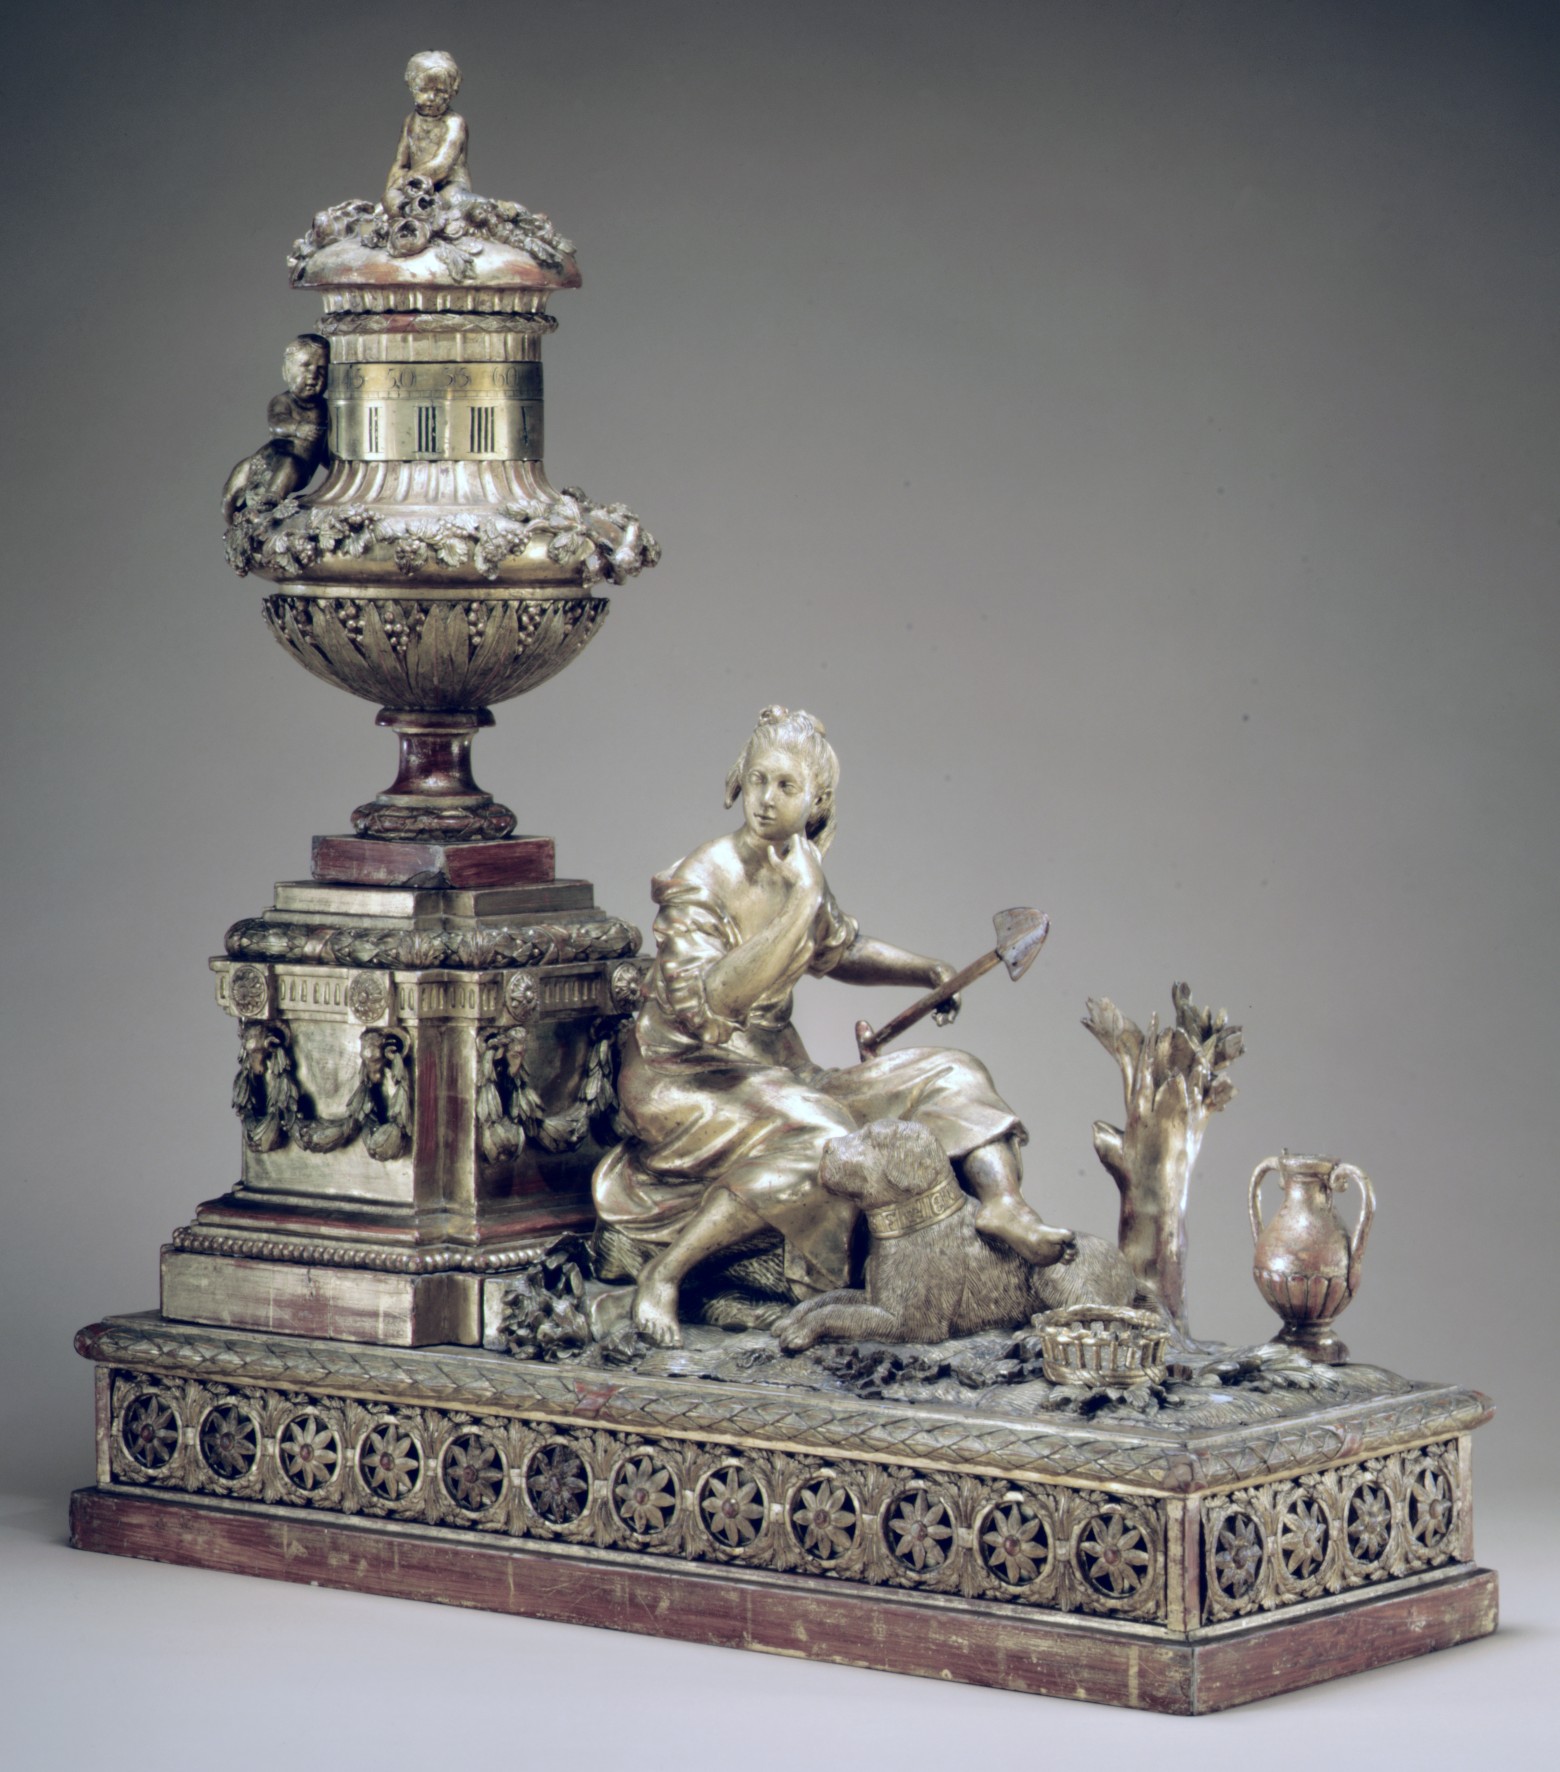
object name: mantel clock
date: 1780-1790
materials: brass, gilt brass, steel, wood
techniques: carving, gilding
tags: children,women,dogs